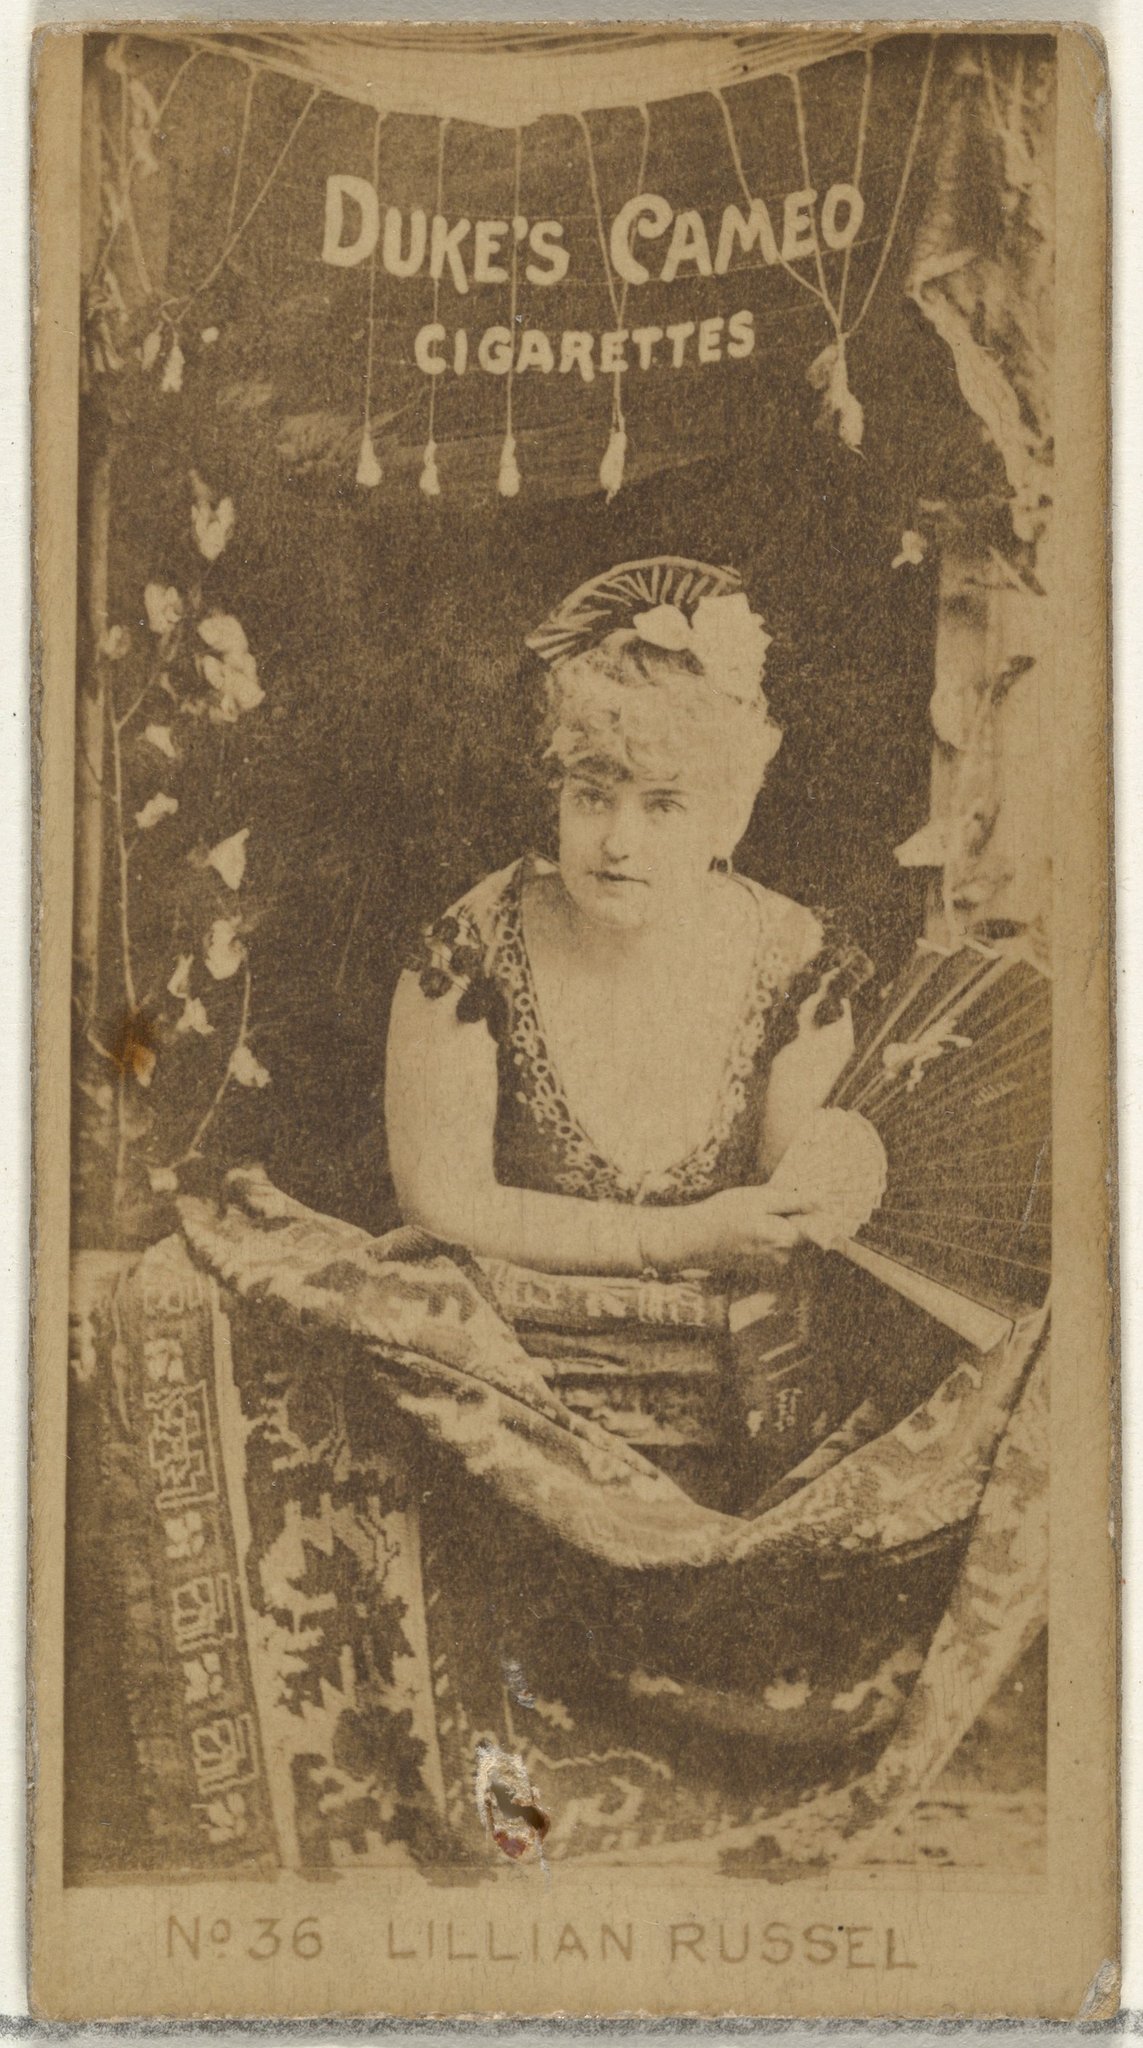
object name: photograph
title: Card Number 36, from the Actors and Actresses series (N145-4) issued by Duke Sons & Co. to promote Cameo Cigarettes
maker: w. duke, sons & co.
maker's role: publisher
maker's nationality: american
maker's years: 1870-1920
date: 1880-1889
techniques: albumen silver print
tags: portraits,women,actresses